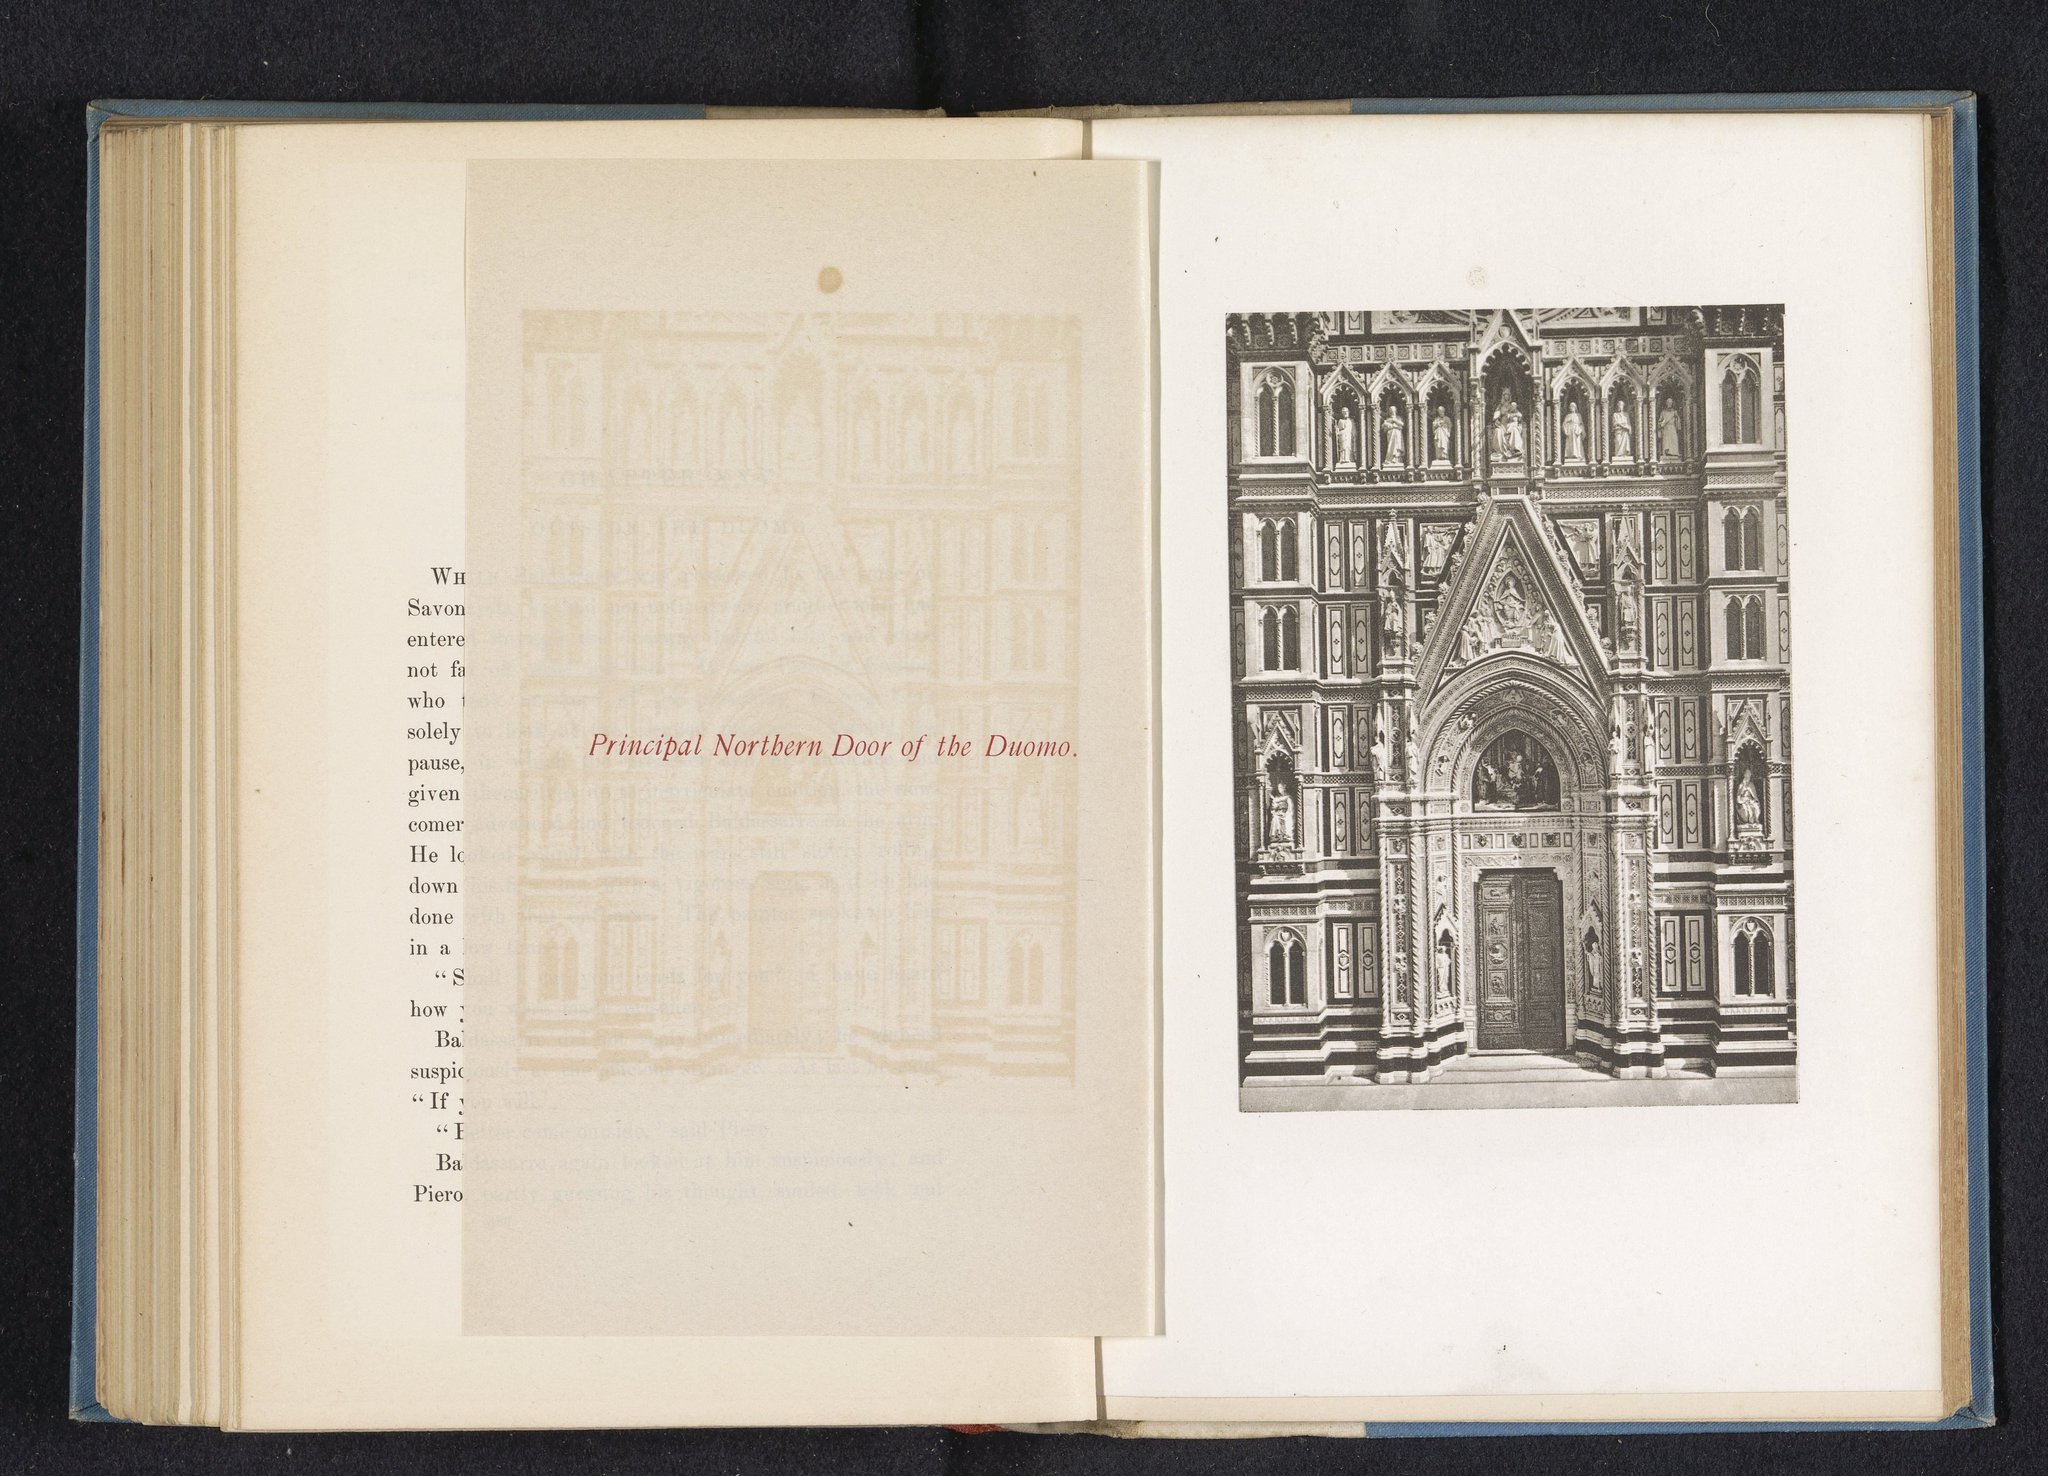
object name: page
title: Toegangsportaal van de Dom van Florence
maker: Anonymous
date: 1880-1890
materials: paper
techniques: photoaquatint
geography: florence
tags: parts of church exterior and annexes: portal, church (exterior)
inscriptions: title: ‘Principal Northern Door of the Duomo.’